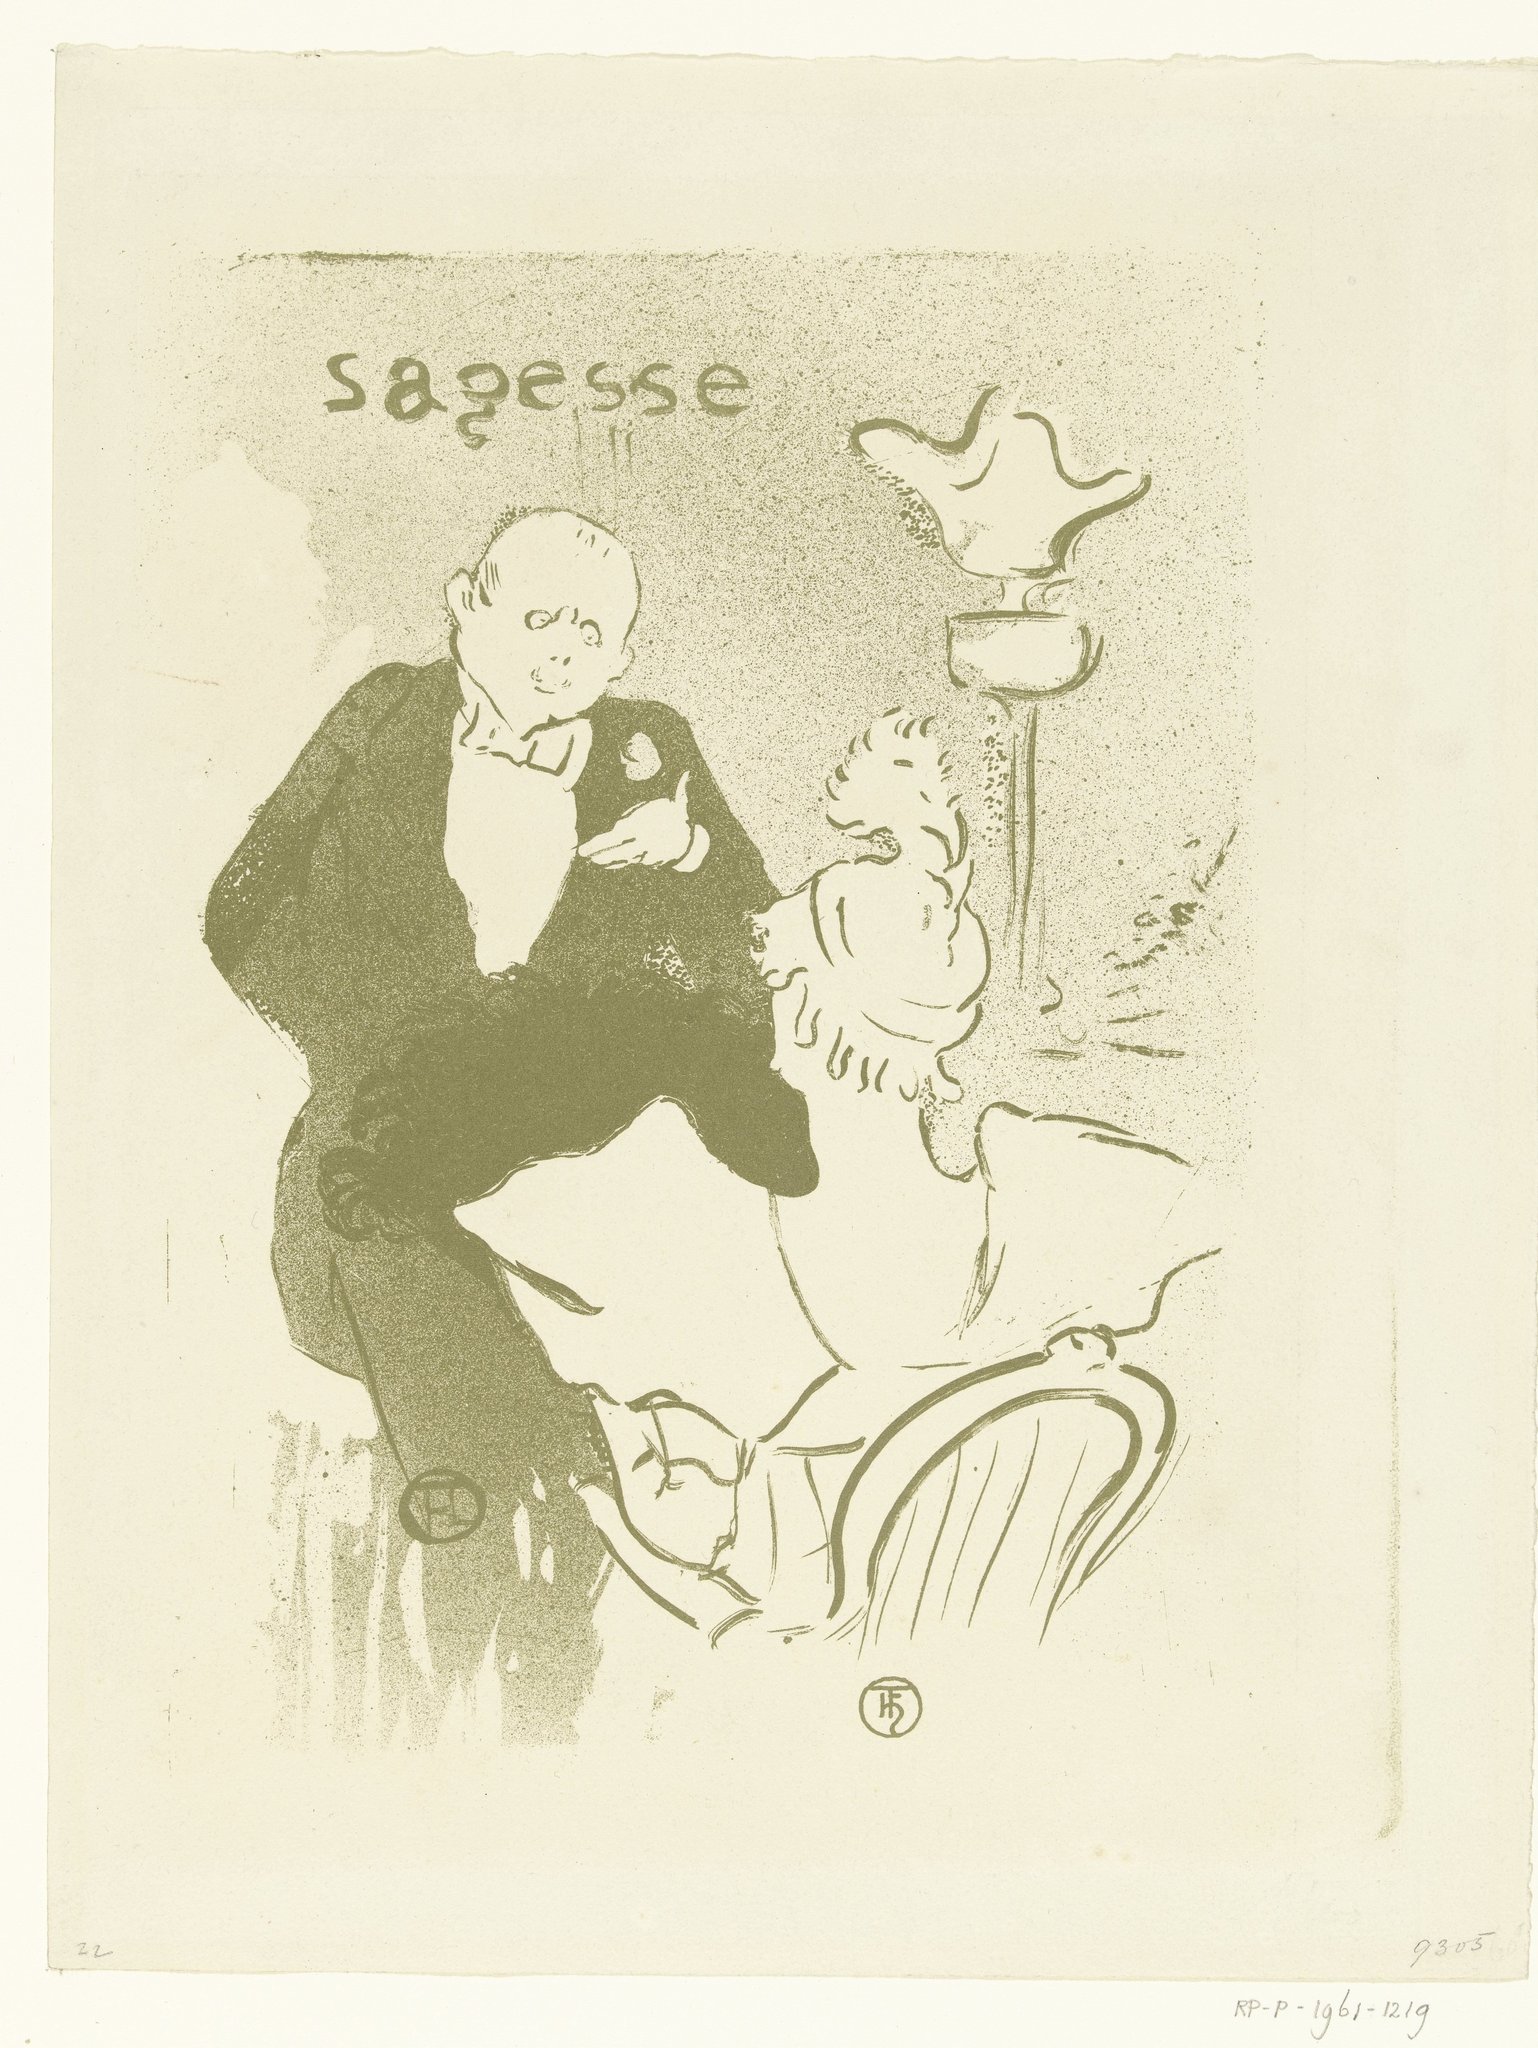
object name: print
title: Sagesse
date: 1893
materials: paper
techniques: printing, lithograph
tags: female sex; woman, male sex; man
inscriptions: collector's mark: Lugt 2228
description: Lithografie verschenen bij: Maurice Joyant, Henri Toulouse-Lautrec 1864-1901 Dessins-Estampes-Affiches, 1927. Bij ieder boek twee drukken, een prent in zwart en een prent in olijfgroen, gedrukt en uitgegeven door Henri Floury.